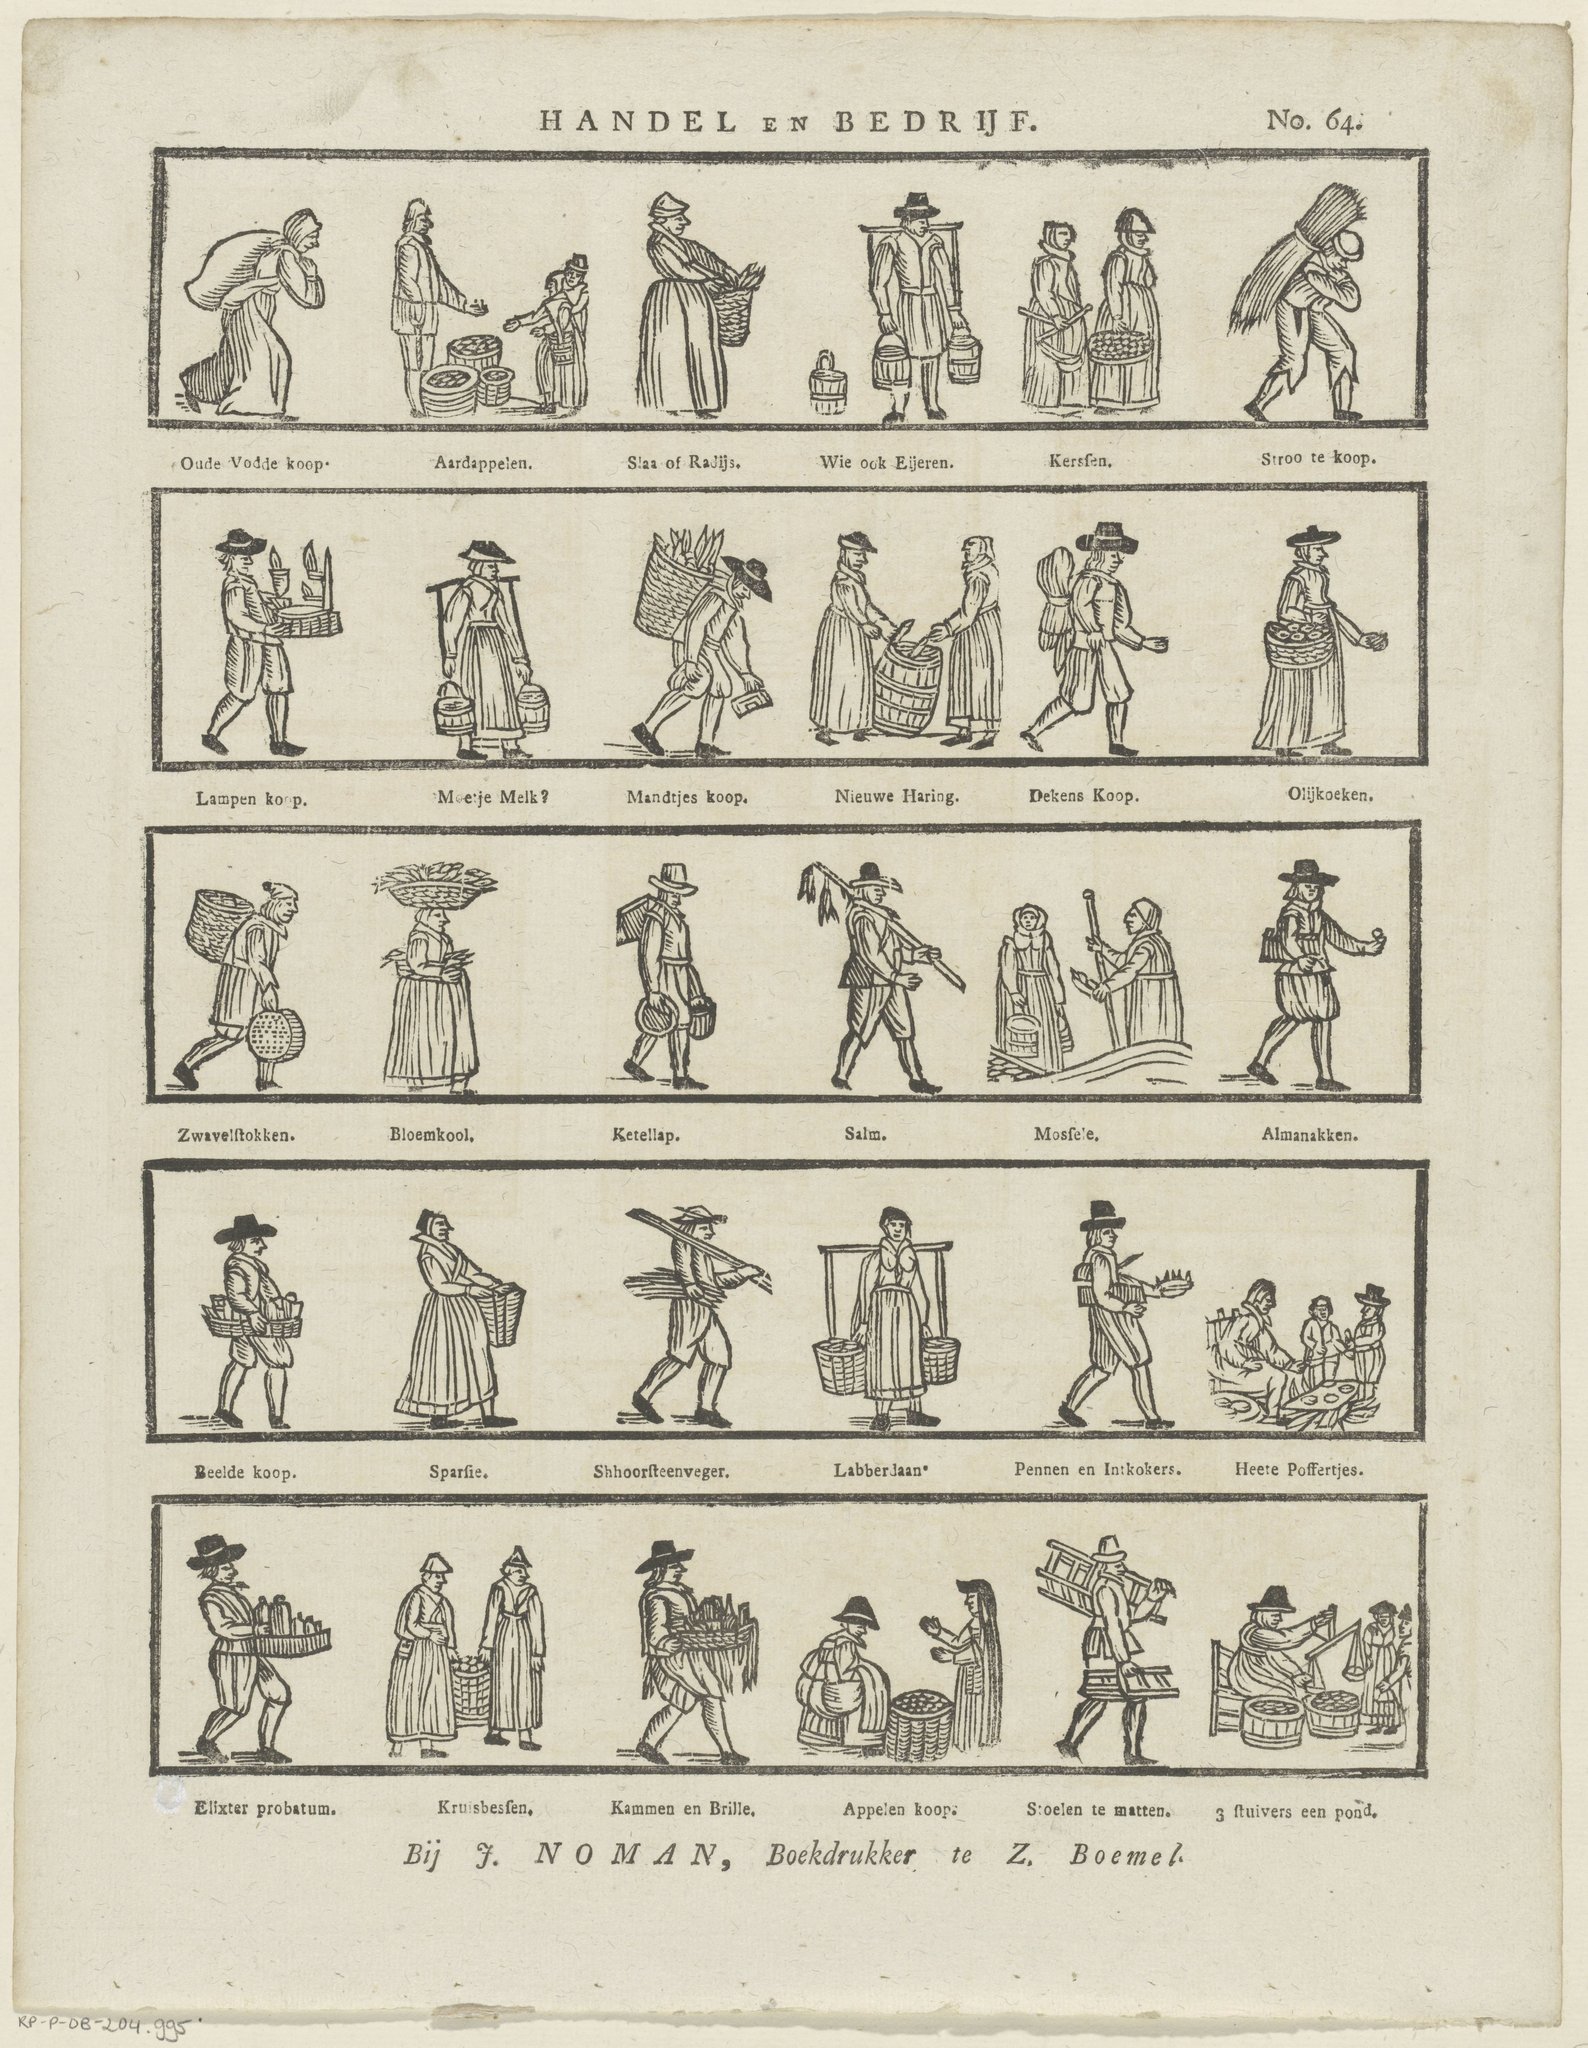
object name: print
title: Handel en bedrijf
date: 1806-1830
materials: paper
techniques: letterpress printing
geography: zaltbommel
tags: street-trader, merchant, salesman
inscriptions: collector's mark: Lugt 2760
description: Blad met 5 horizontale rijen met voorstellingen van straatverkopers. Onder elke figuur een onderschrift. Genummerd rechtsboven: No. 64.